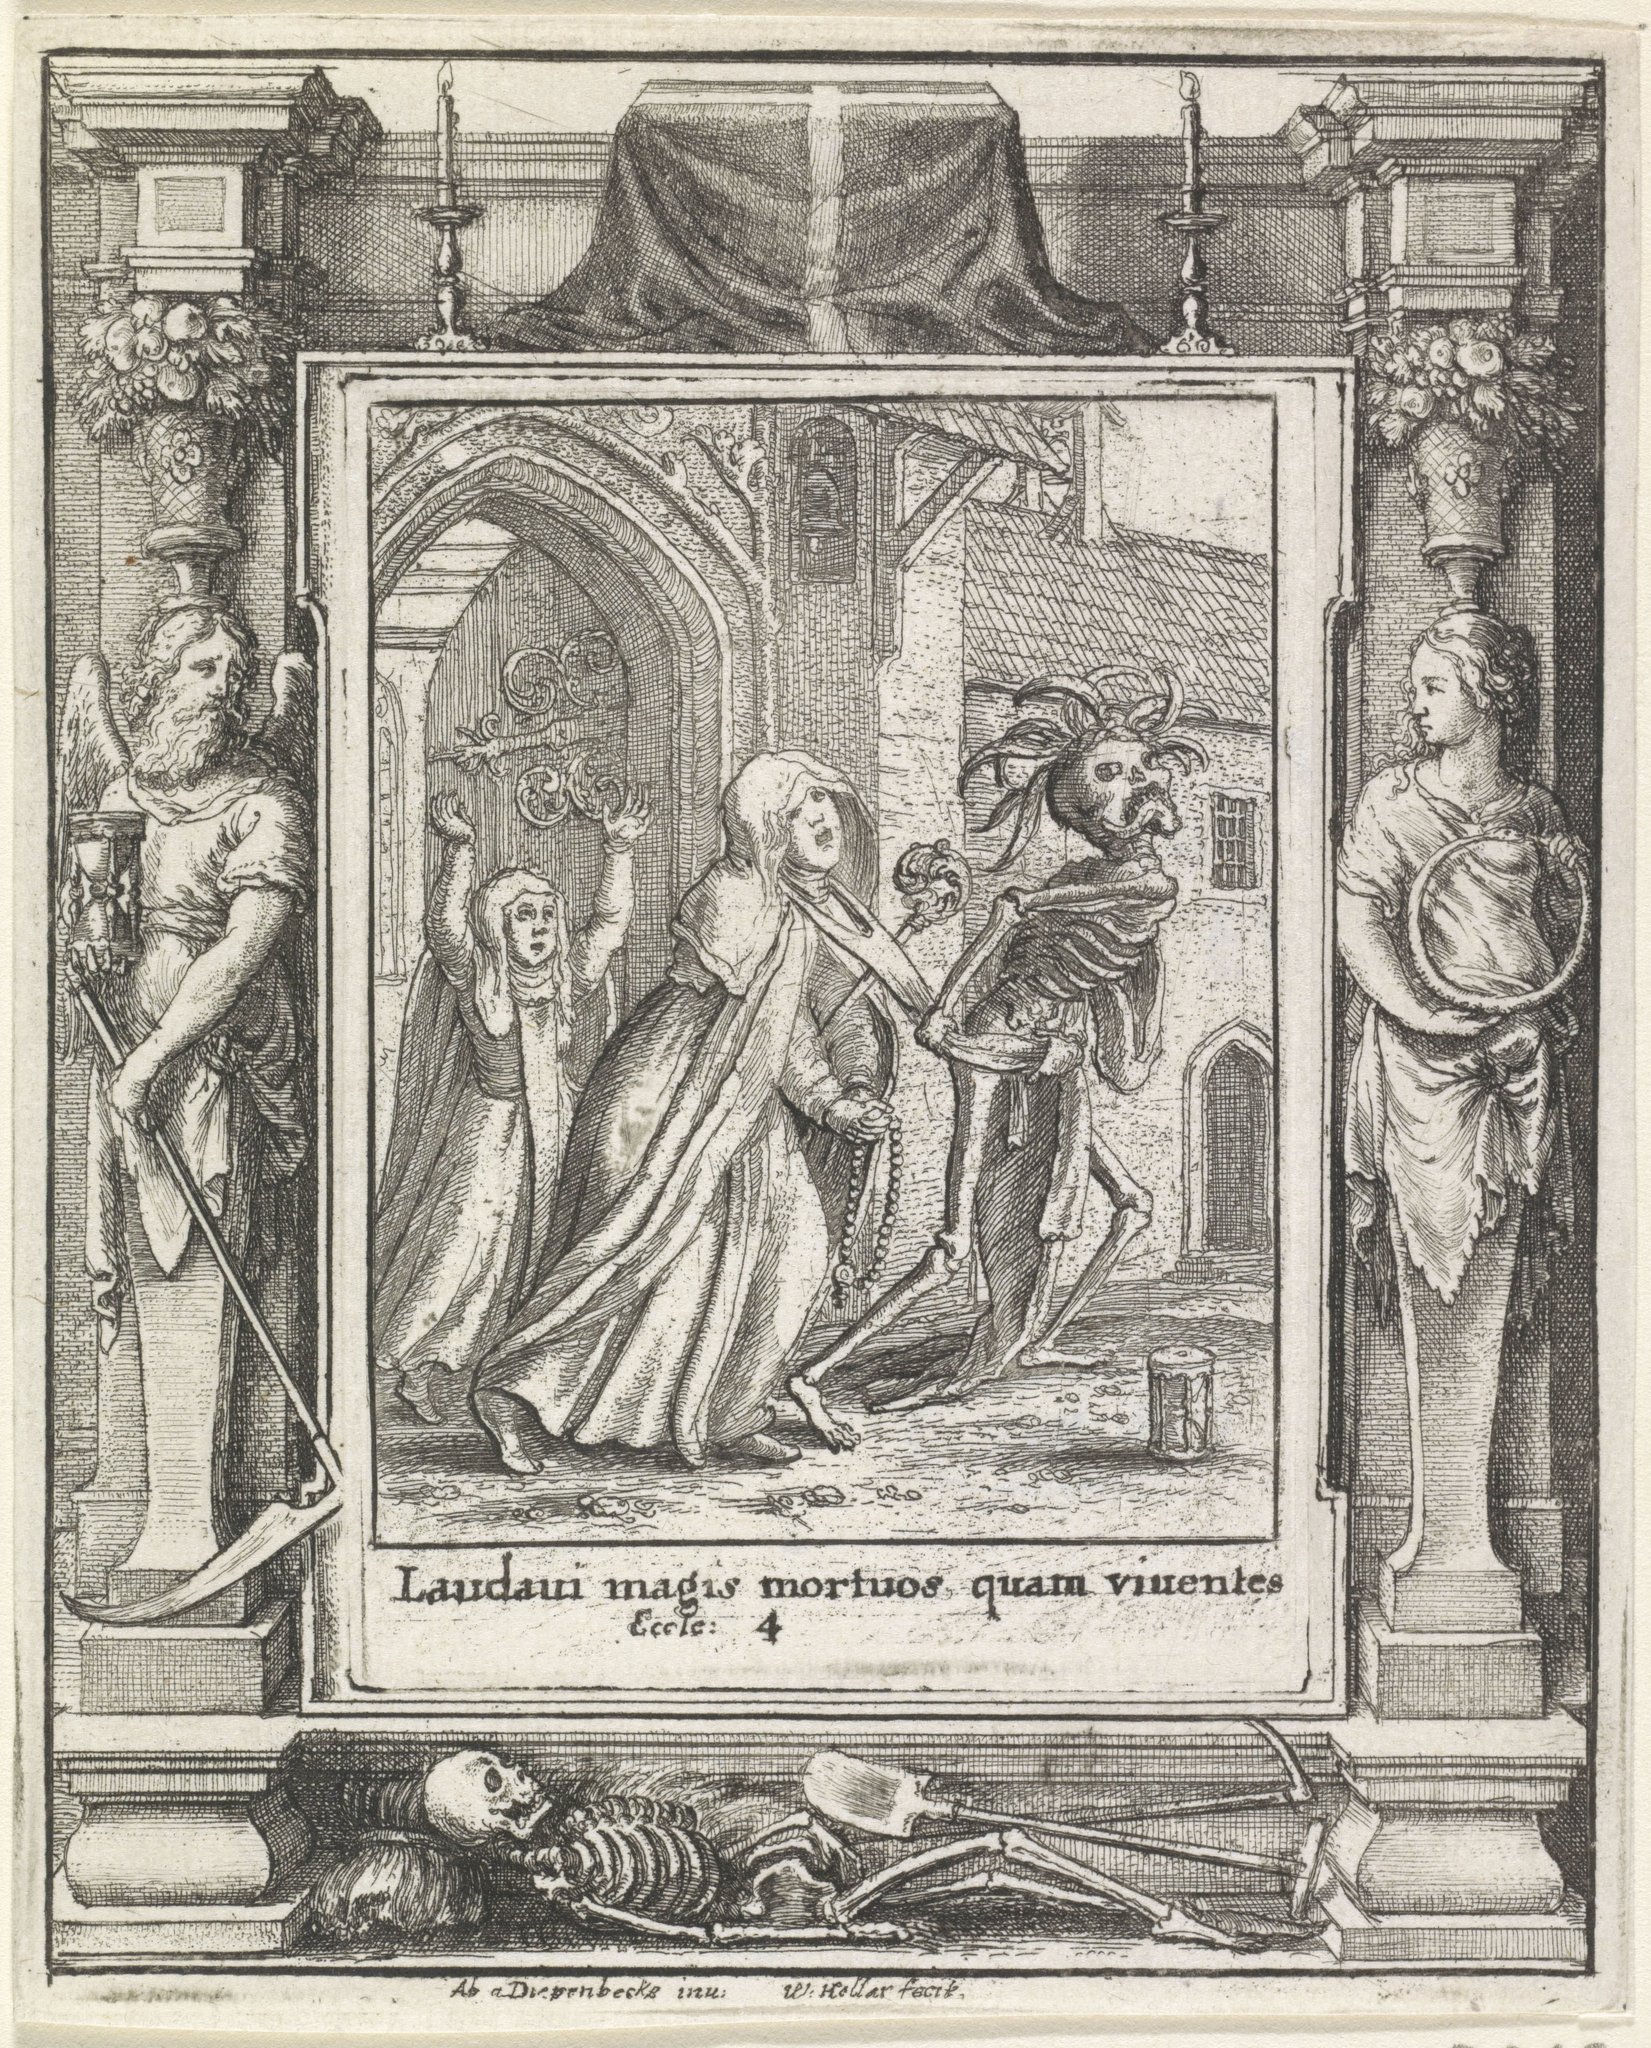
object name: print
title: Dodendans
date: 1651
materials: paper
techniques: etching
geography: antwerp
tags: dance of death; death together with one or more human beings, eternity, 'aeternitas'; 'eternità','eternità o perpetuità' (ripa), father time, man with wings and scythe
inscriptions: collector's mark: Lugt 2228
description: De Dood trekt een abdis aan haar habijt uit het klooster. Veertiende prent uit een reeks van 30 dodendansprenten; met een omlijsting met Vader Tijd en Eeuwigheid.